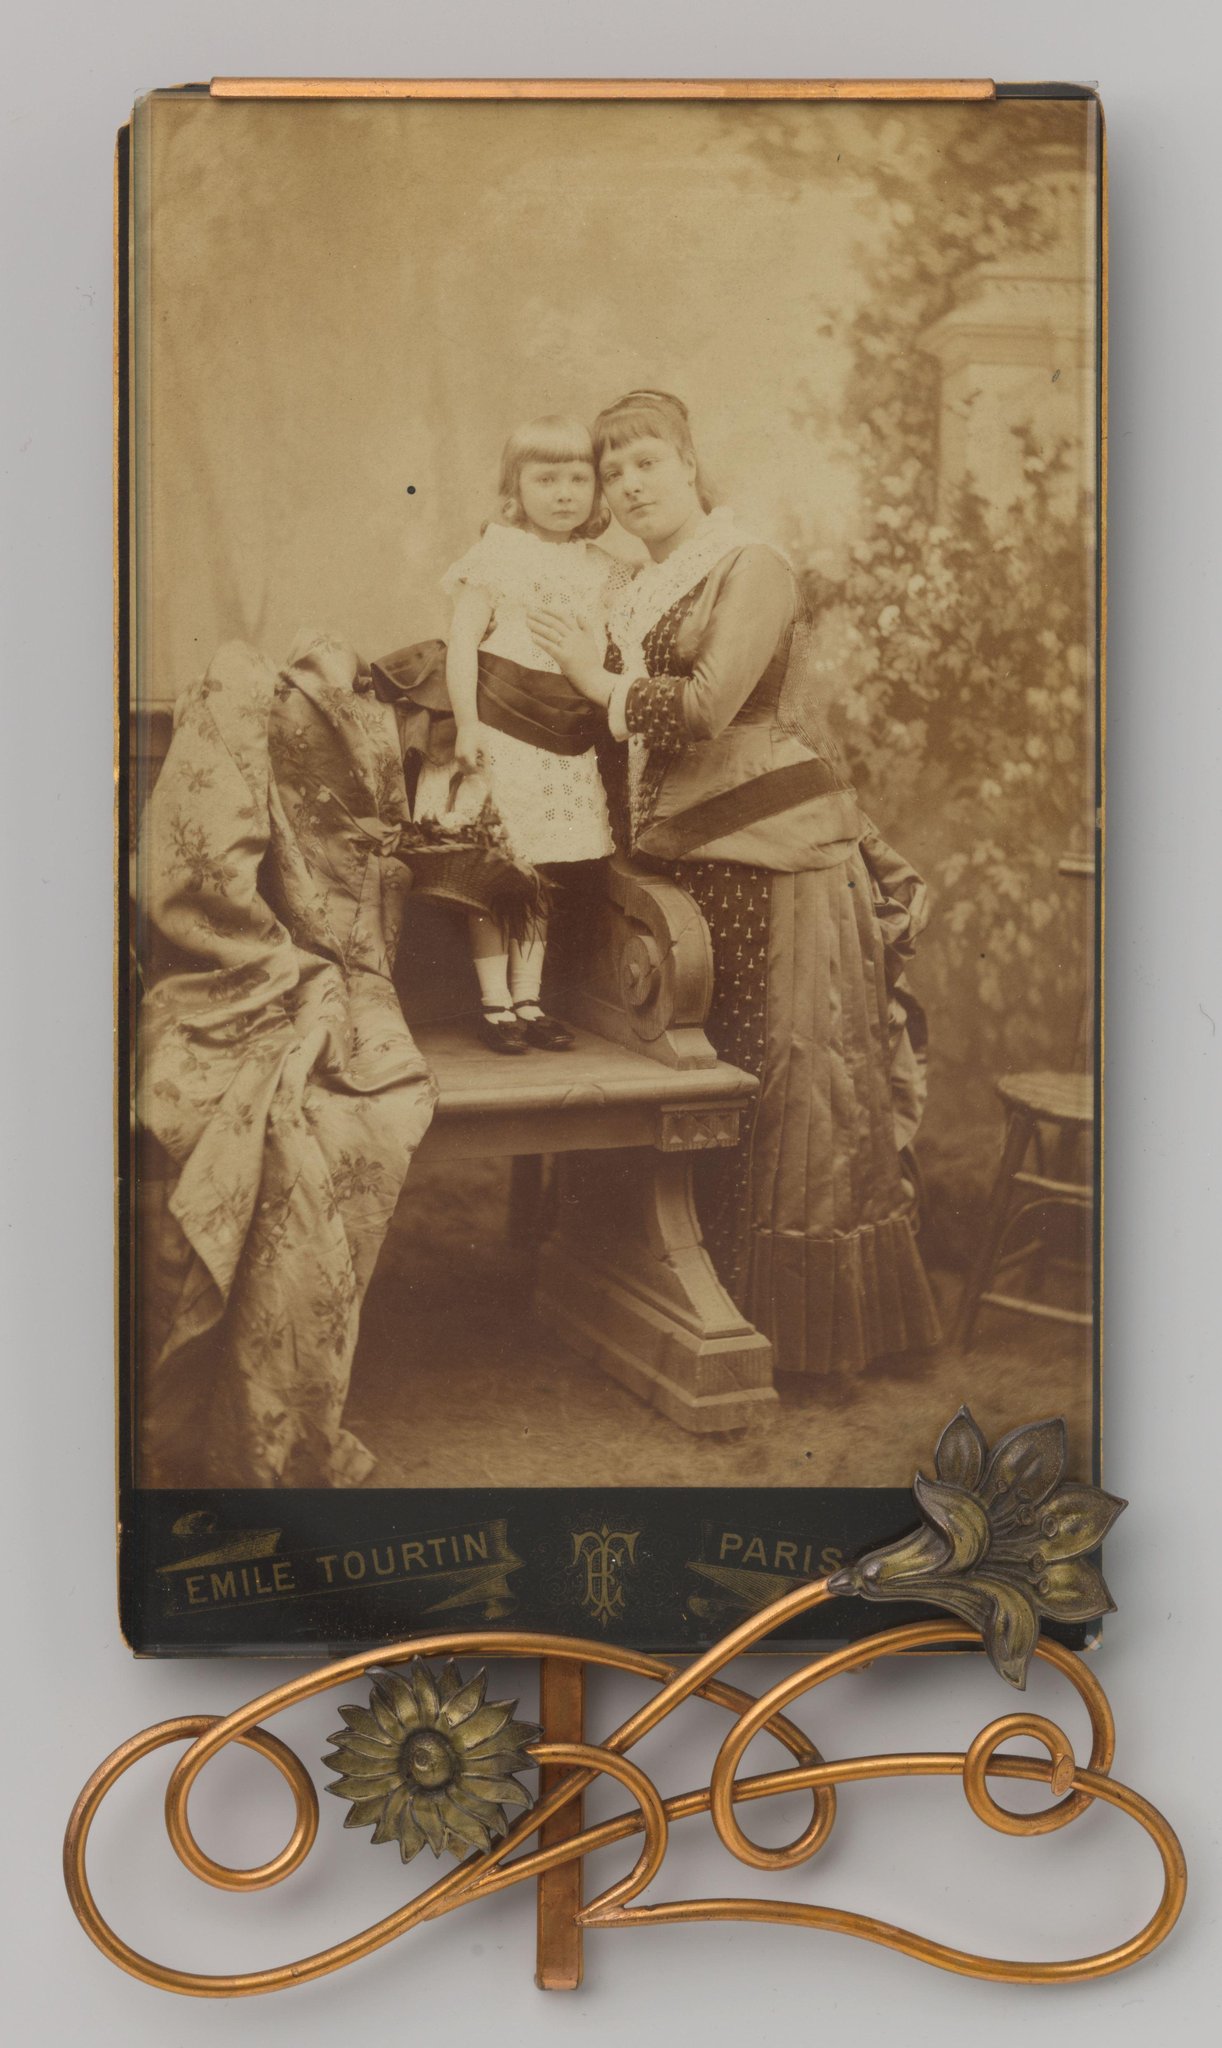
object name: photograph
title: Portret van een onbekende vrouw met kind op een bank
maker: emile tourtin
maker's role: fotograaf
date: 1875-1890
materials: cardboard, glass, metal, paper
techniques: albumen print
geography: paris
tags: adult woman, anonymous historical person portrayed, mother and child(ren), woman and child(ren) (family group), child between toddler and youth (of undetermined sex), paris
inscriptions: inscription: ‘Emile Tourtin/ ET/ Paris-Rouen’